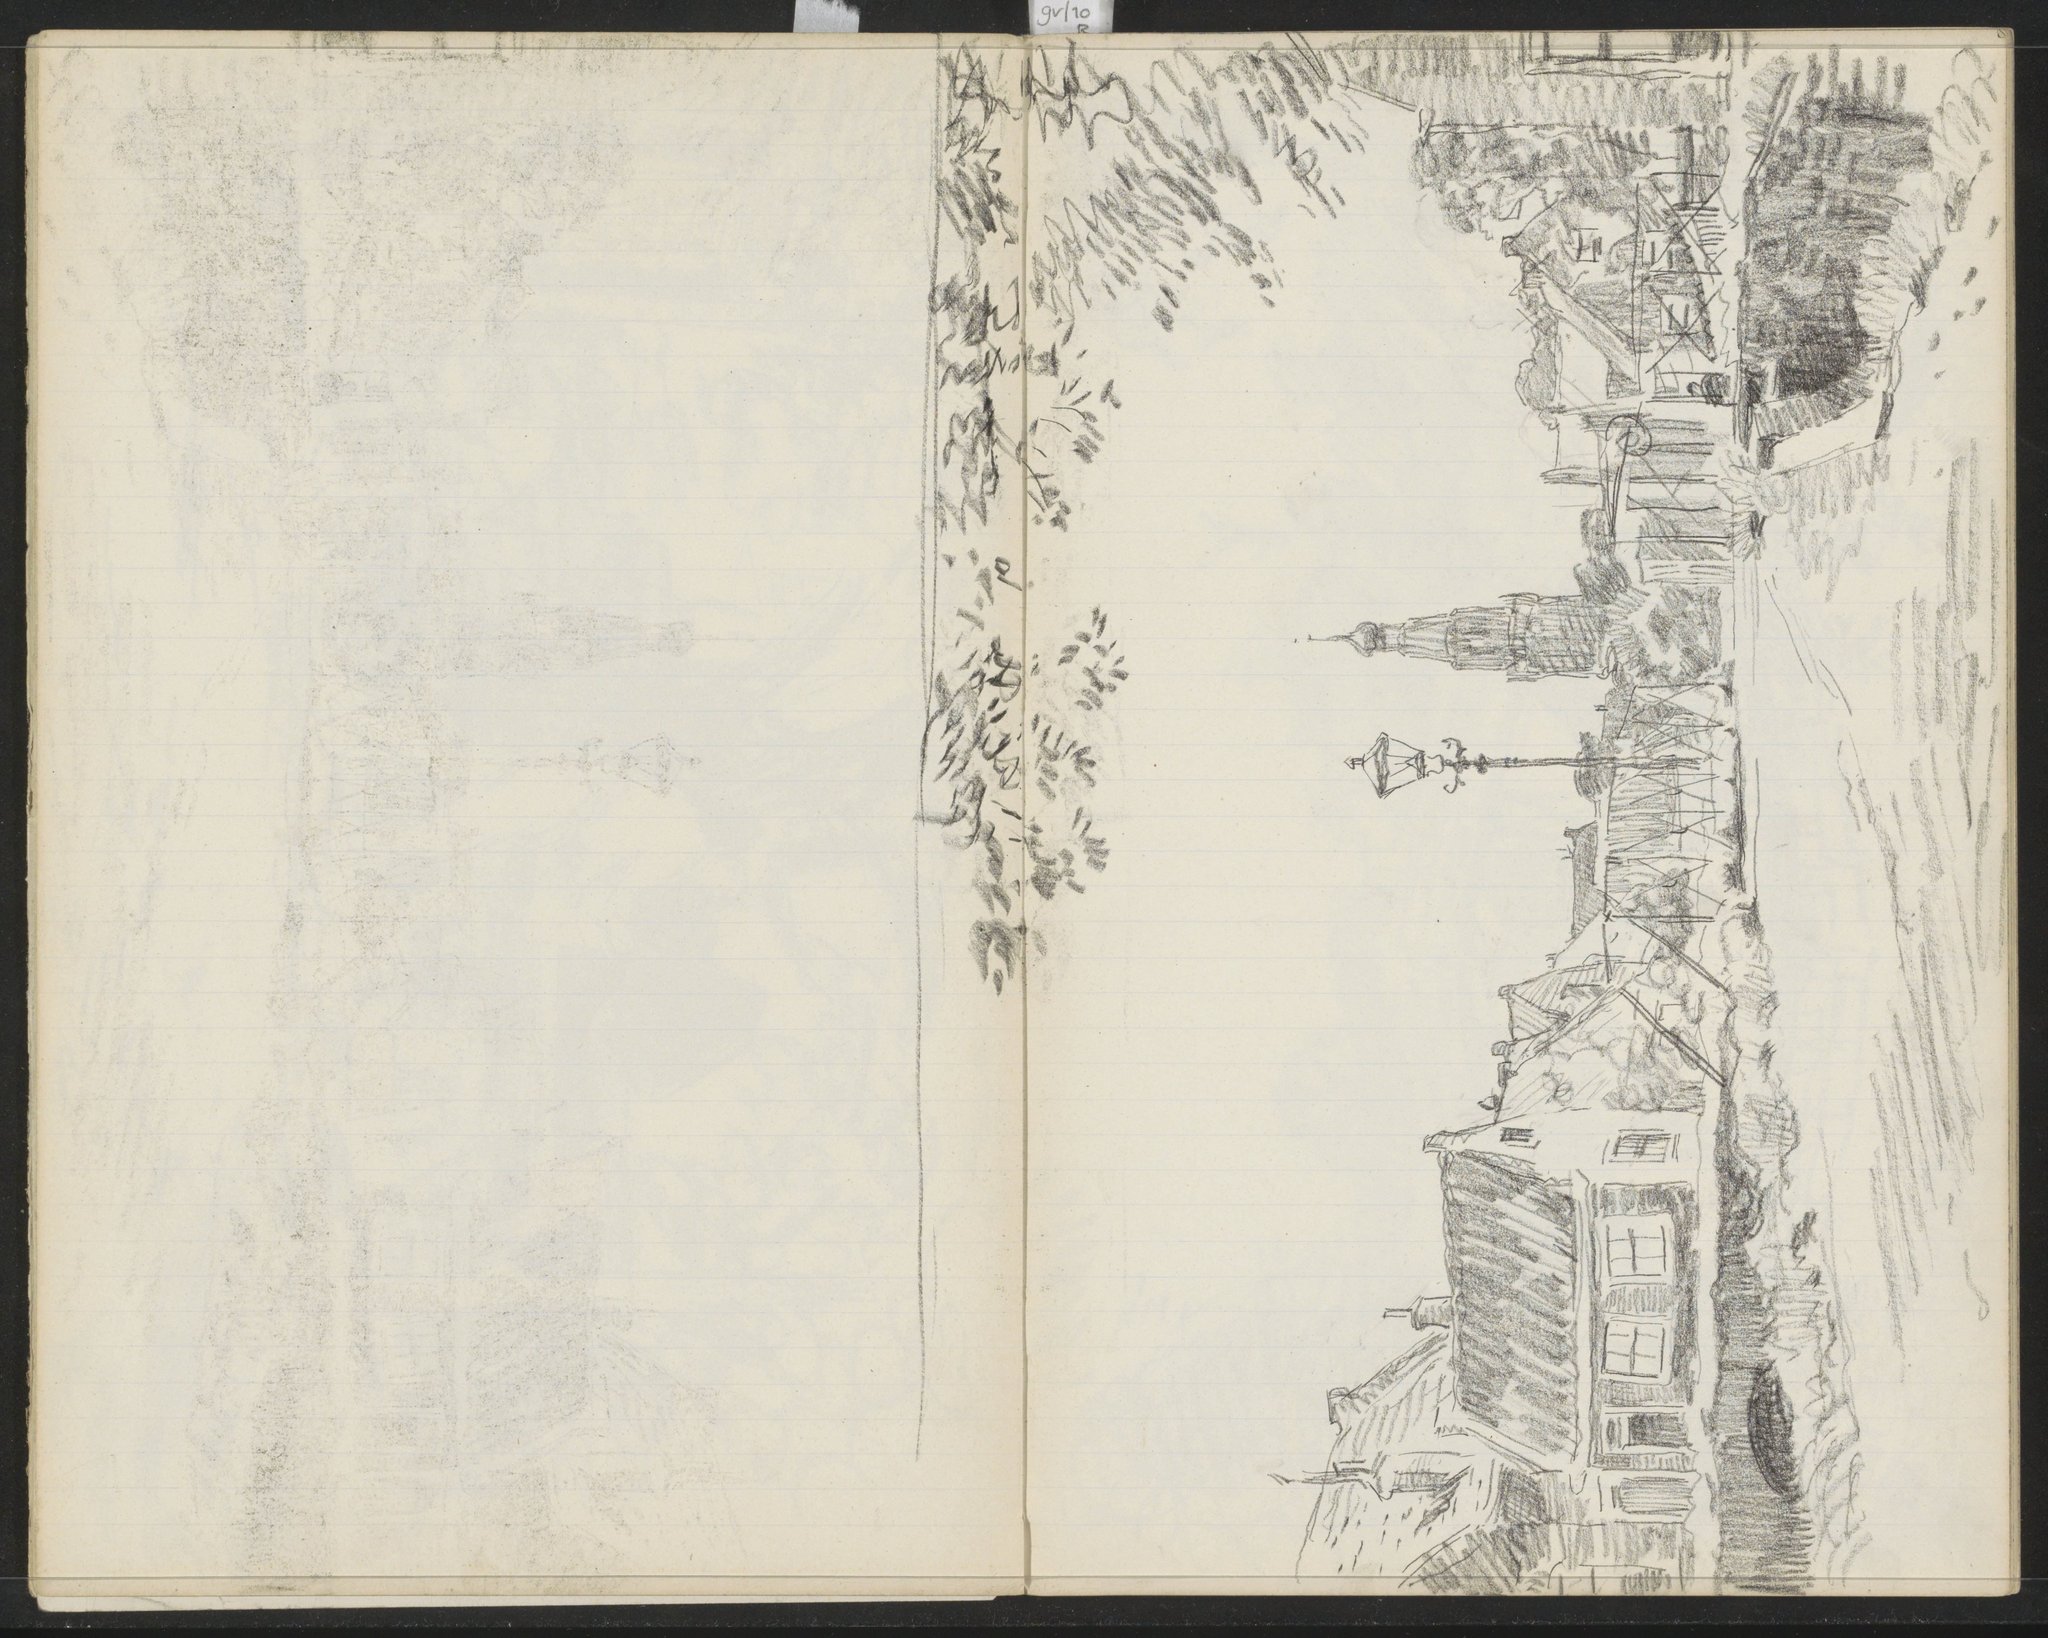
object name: sketchbook leaf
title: Straat langs een kanaal met zicht op de Zuiderkerk in Enkhuizen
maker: willem bastiaan tholen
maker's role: draughtsman, painter, print maker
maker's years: 1860-1931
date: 1900-1931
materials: chalk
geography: enkhuizen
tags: church (exterior), street lighting, bridge in city across river, canal, etc., street (+ city(-scape) with figures, staffage)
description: Blad 6 verso en 7 recto uit een schetsboek met 55 bladen.